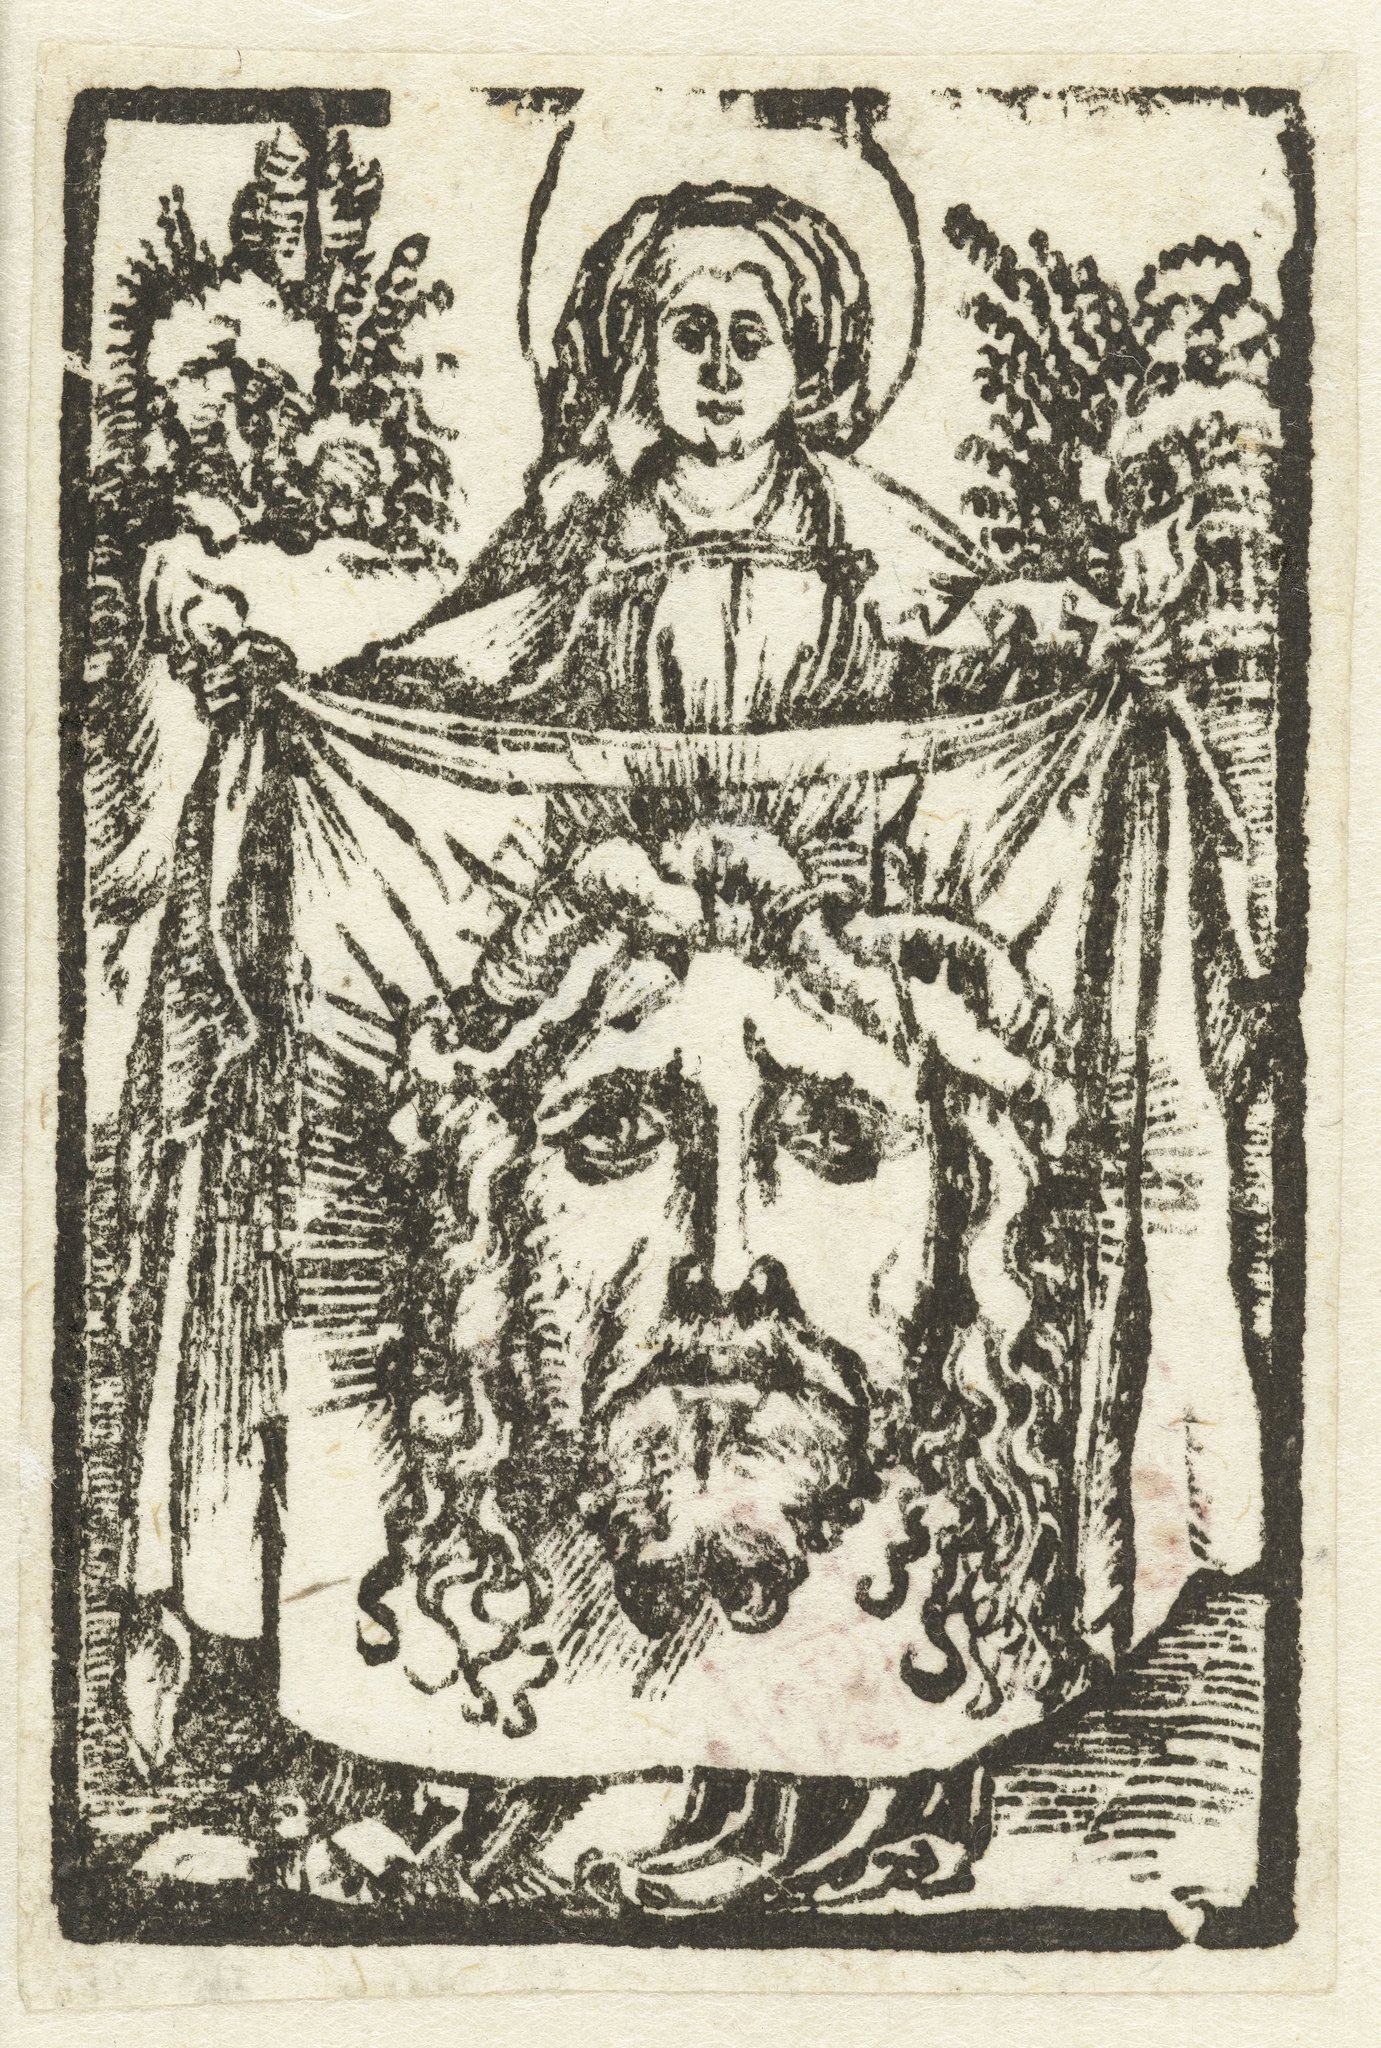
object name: book illustration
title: Heilige Veronica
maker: albrecht dürer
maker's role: draughtsman, painter, print maker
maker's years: 1471-1528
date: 1503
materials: paper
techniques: woodcut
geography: nuremberg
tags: veronica; possible attributes: 'sudarium' (veil with the image of christ), 'vera icon', held up by veronica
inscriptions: collector's mark: Lugt 240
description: Illustratie voor: Salus anim[a]e, Neurenberg: Hieronymus Höltzel, 1503. Klinkert, C.